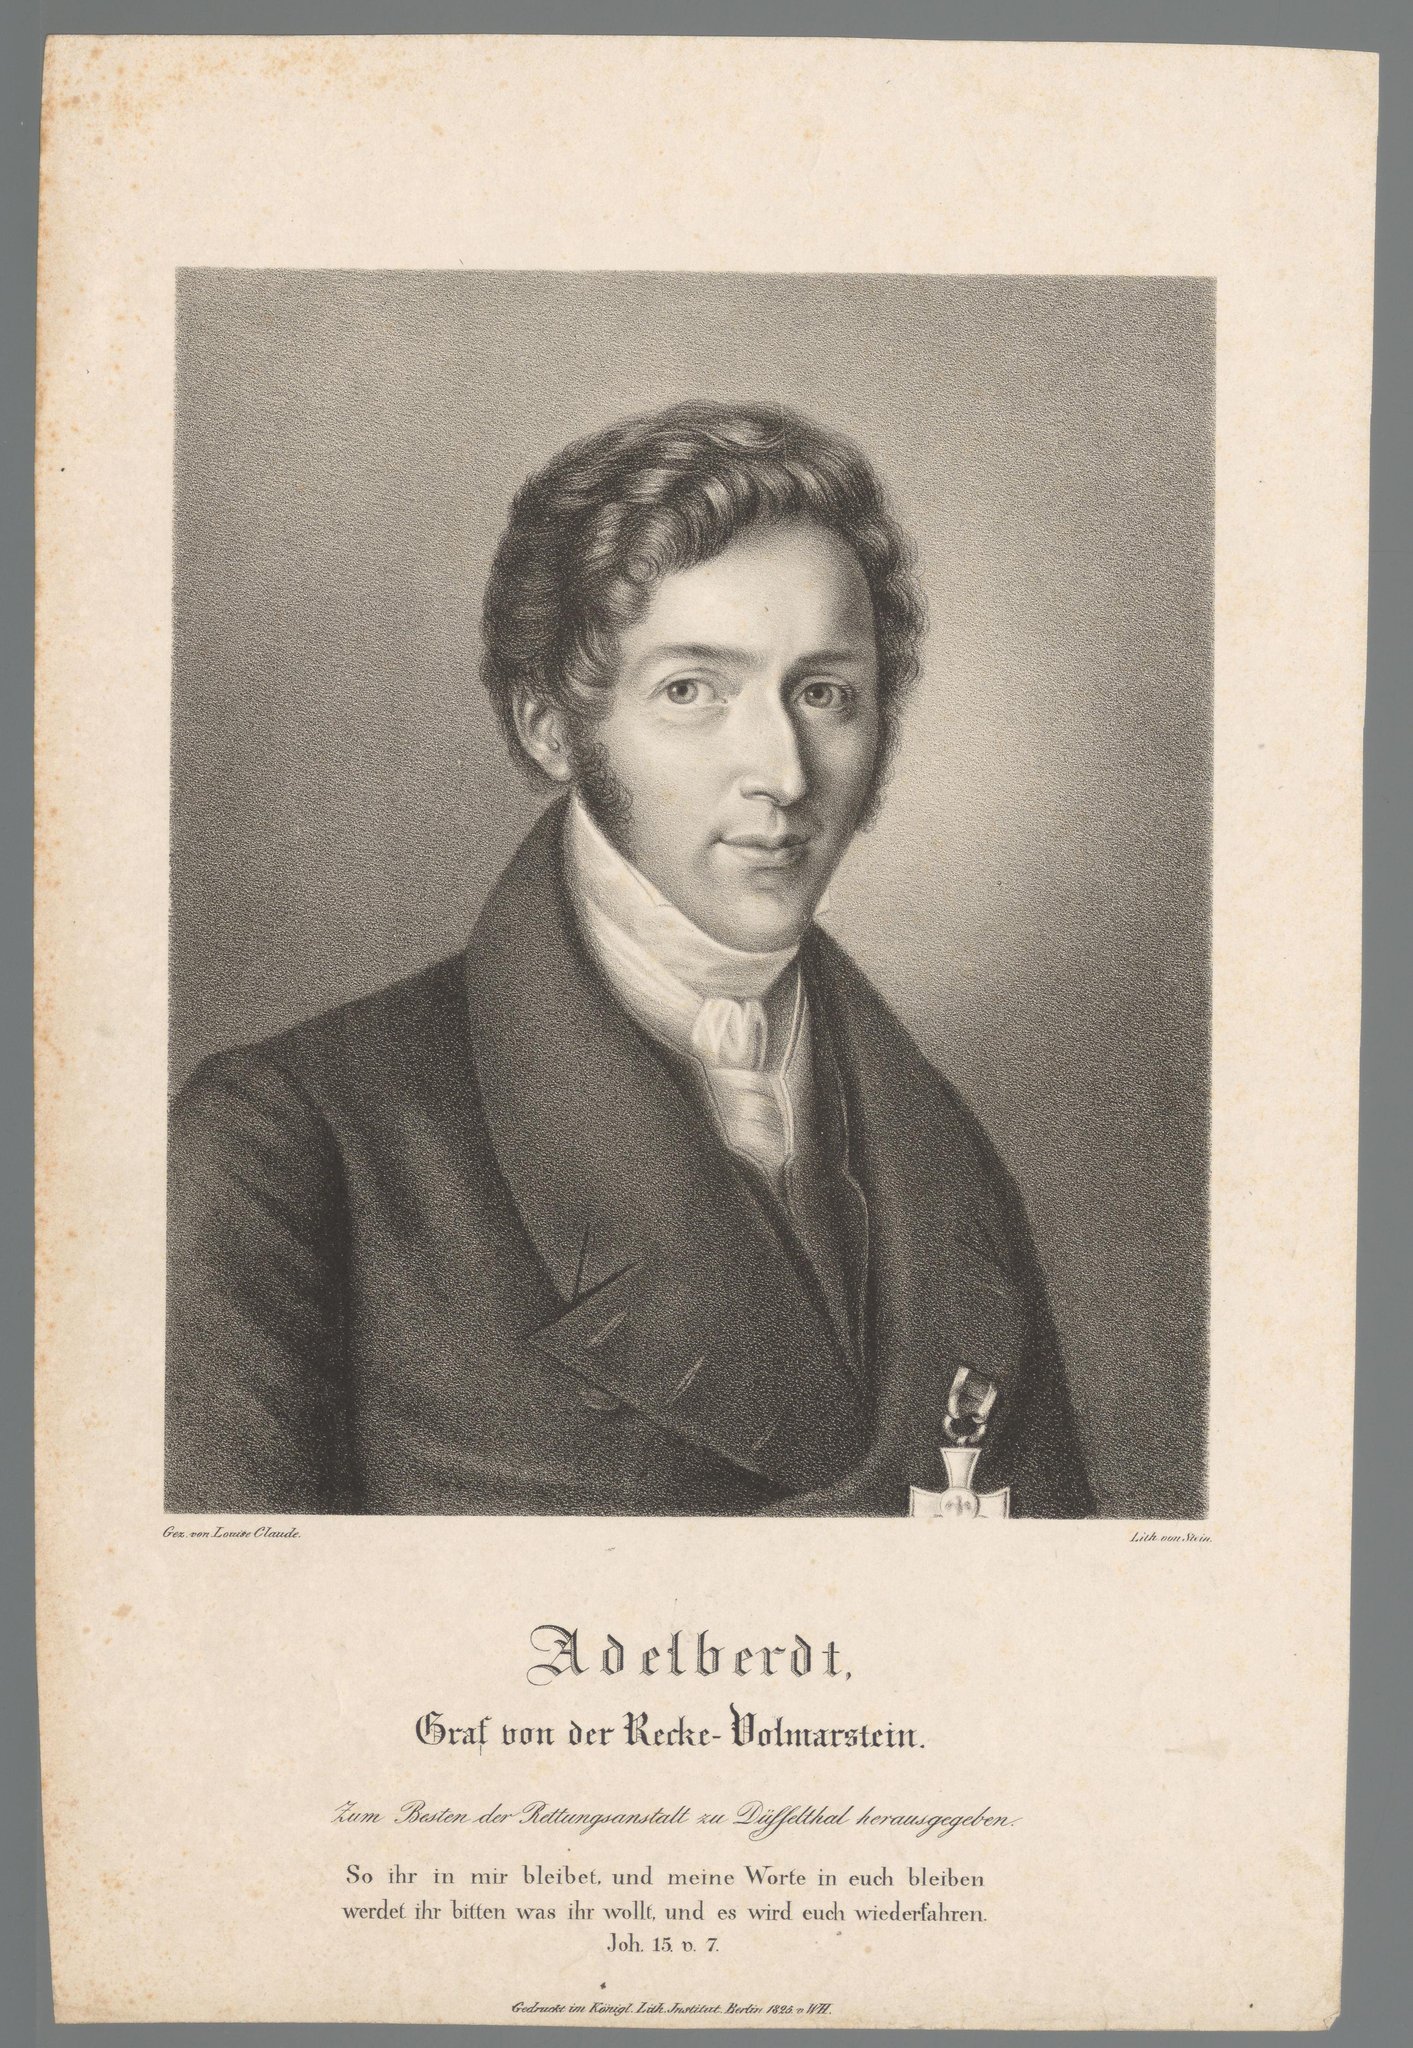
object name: print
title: Portret van Adelberdt von der Recke-Volmerstein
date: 1825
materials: paper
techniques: lithograph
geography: berlin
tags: adult man, historical persons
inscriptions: collector's mark: Lugt 2228